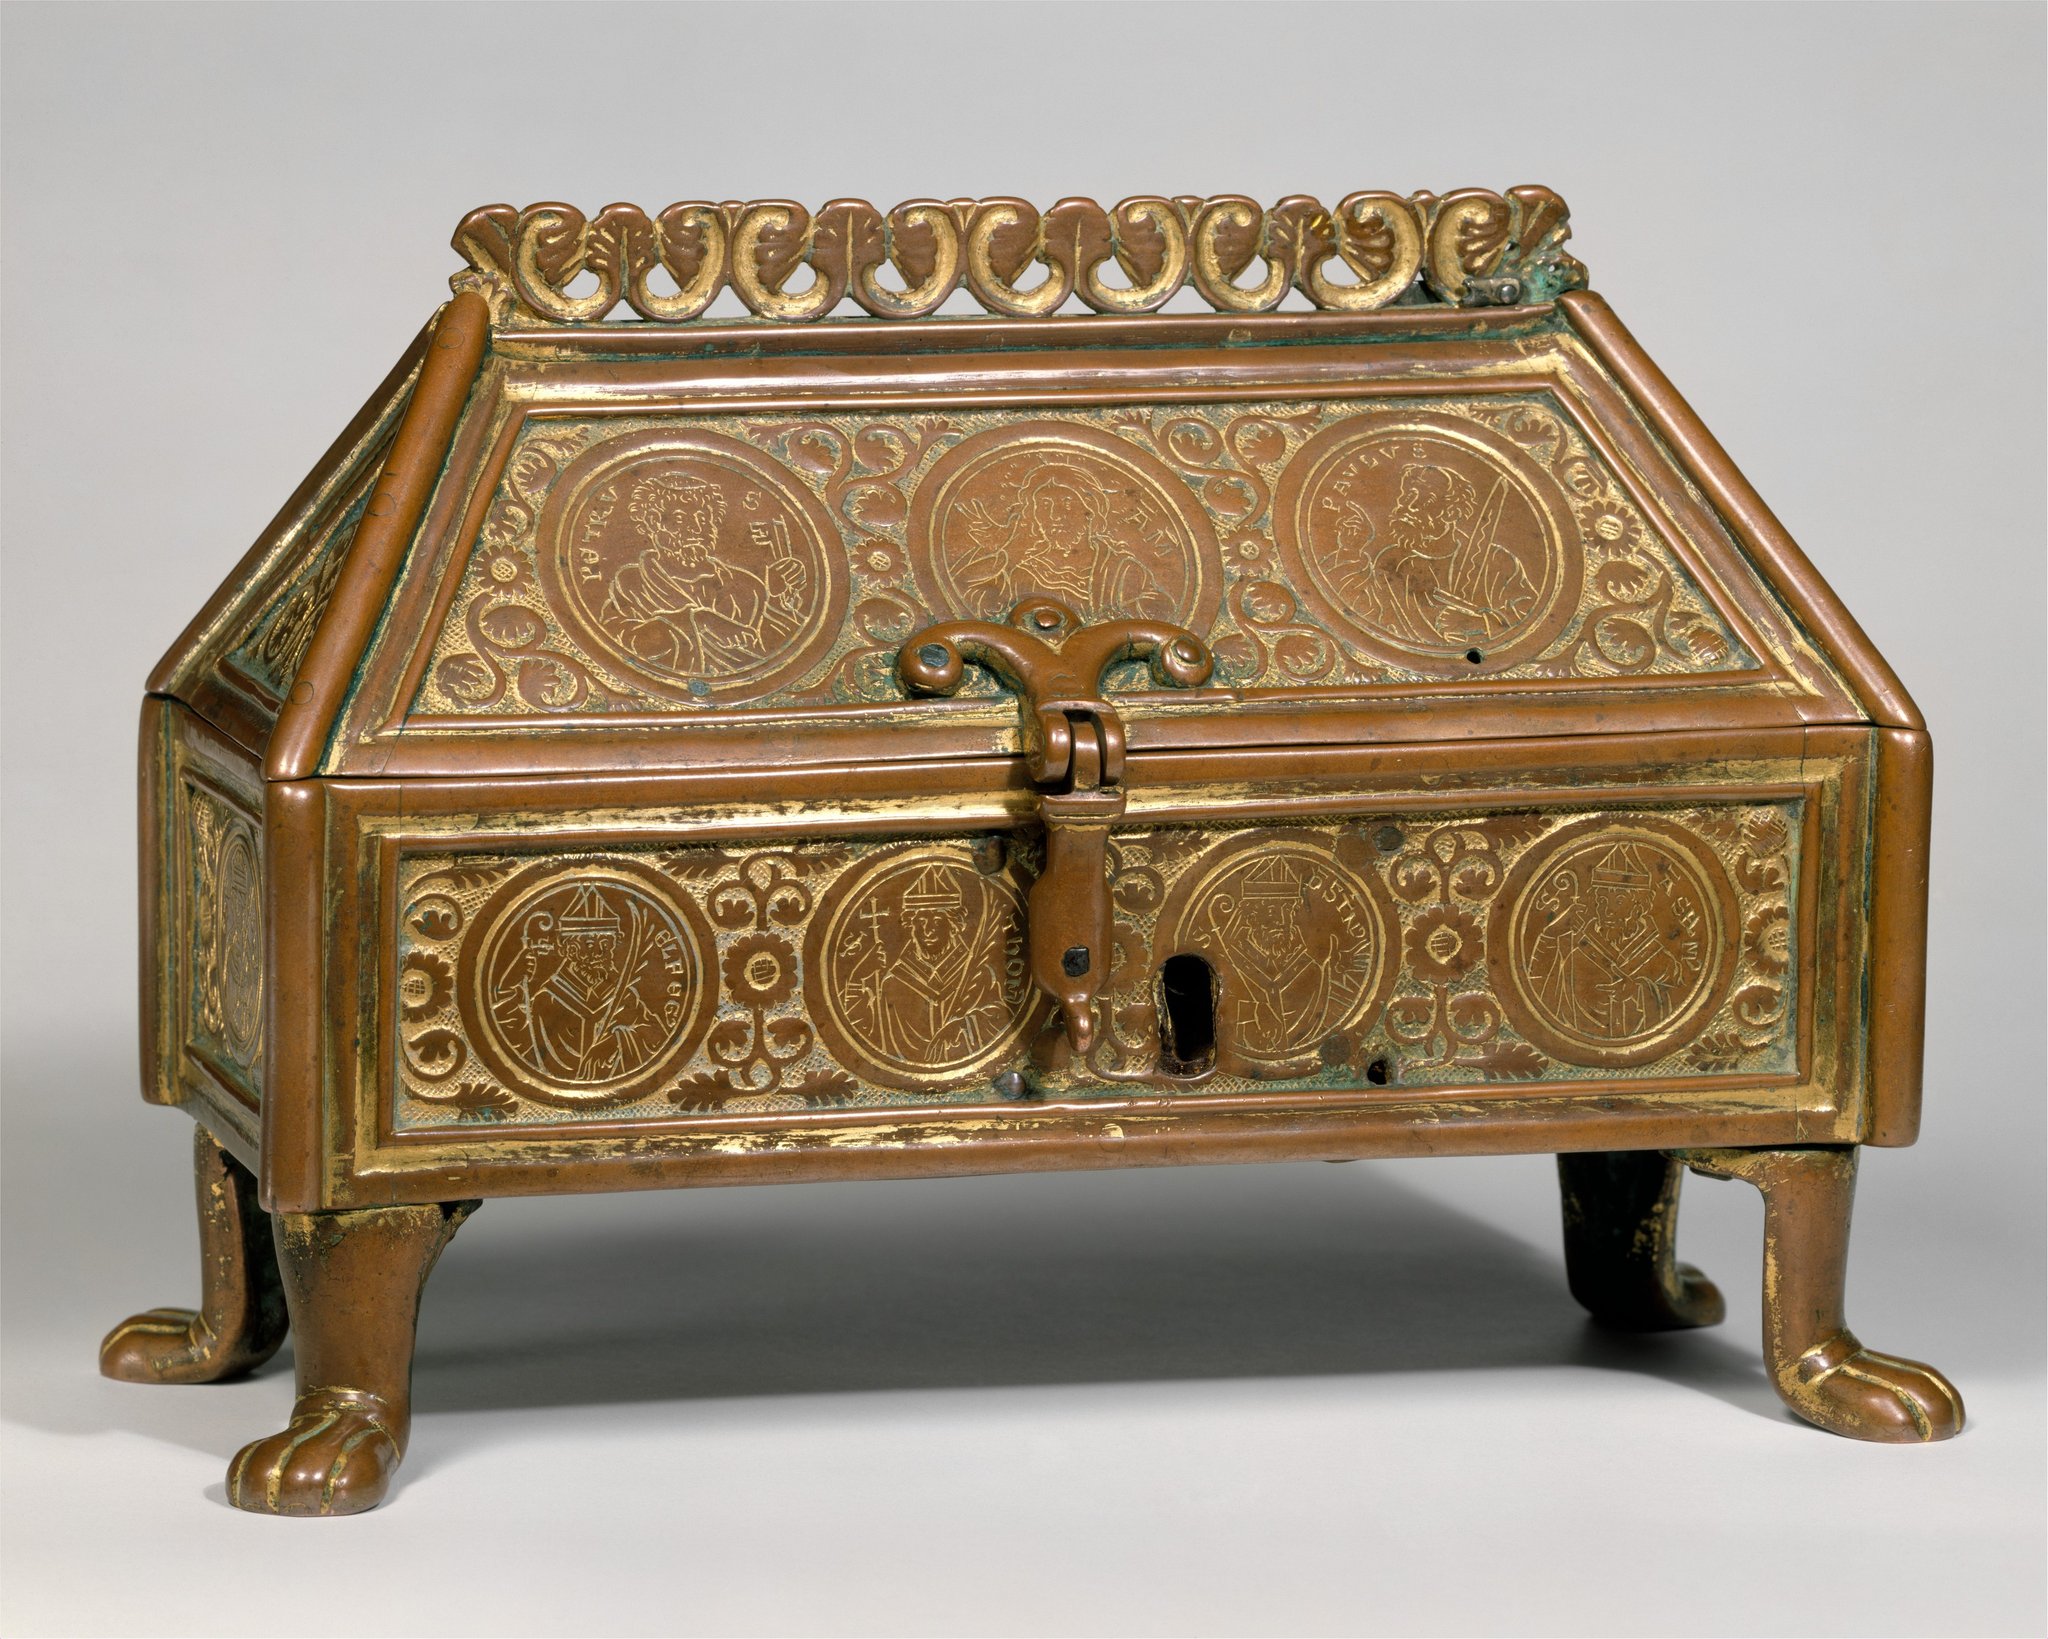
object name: reliquary chasse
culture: british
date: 1207-1213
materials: copper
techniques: casting, chasing, engraving, gilding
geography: england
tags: christ,saint paul,saint peter,virgin mary